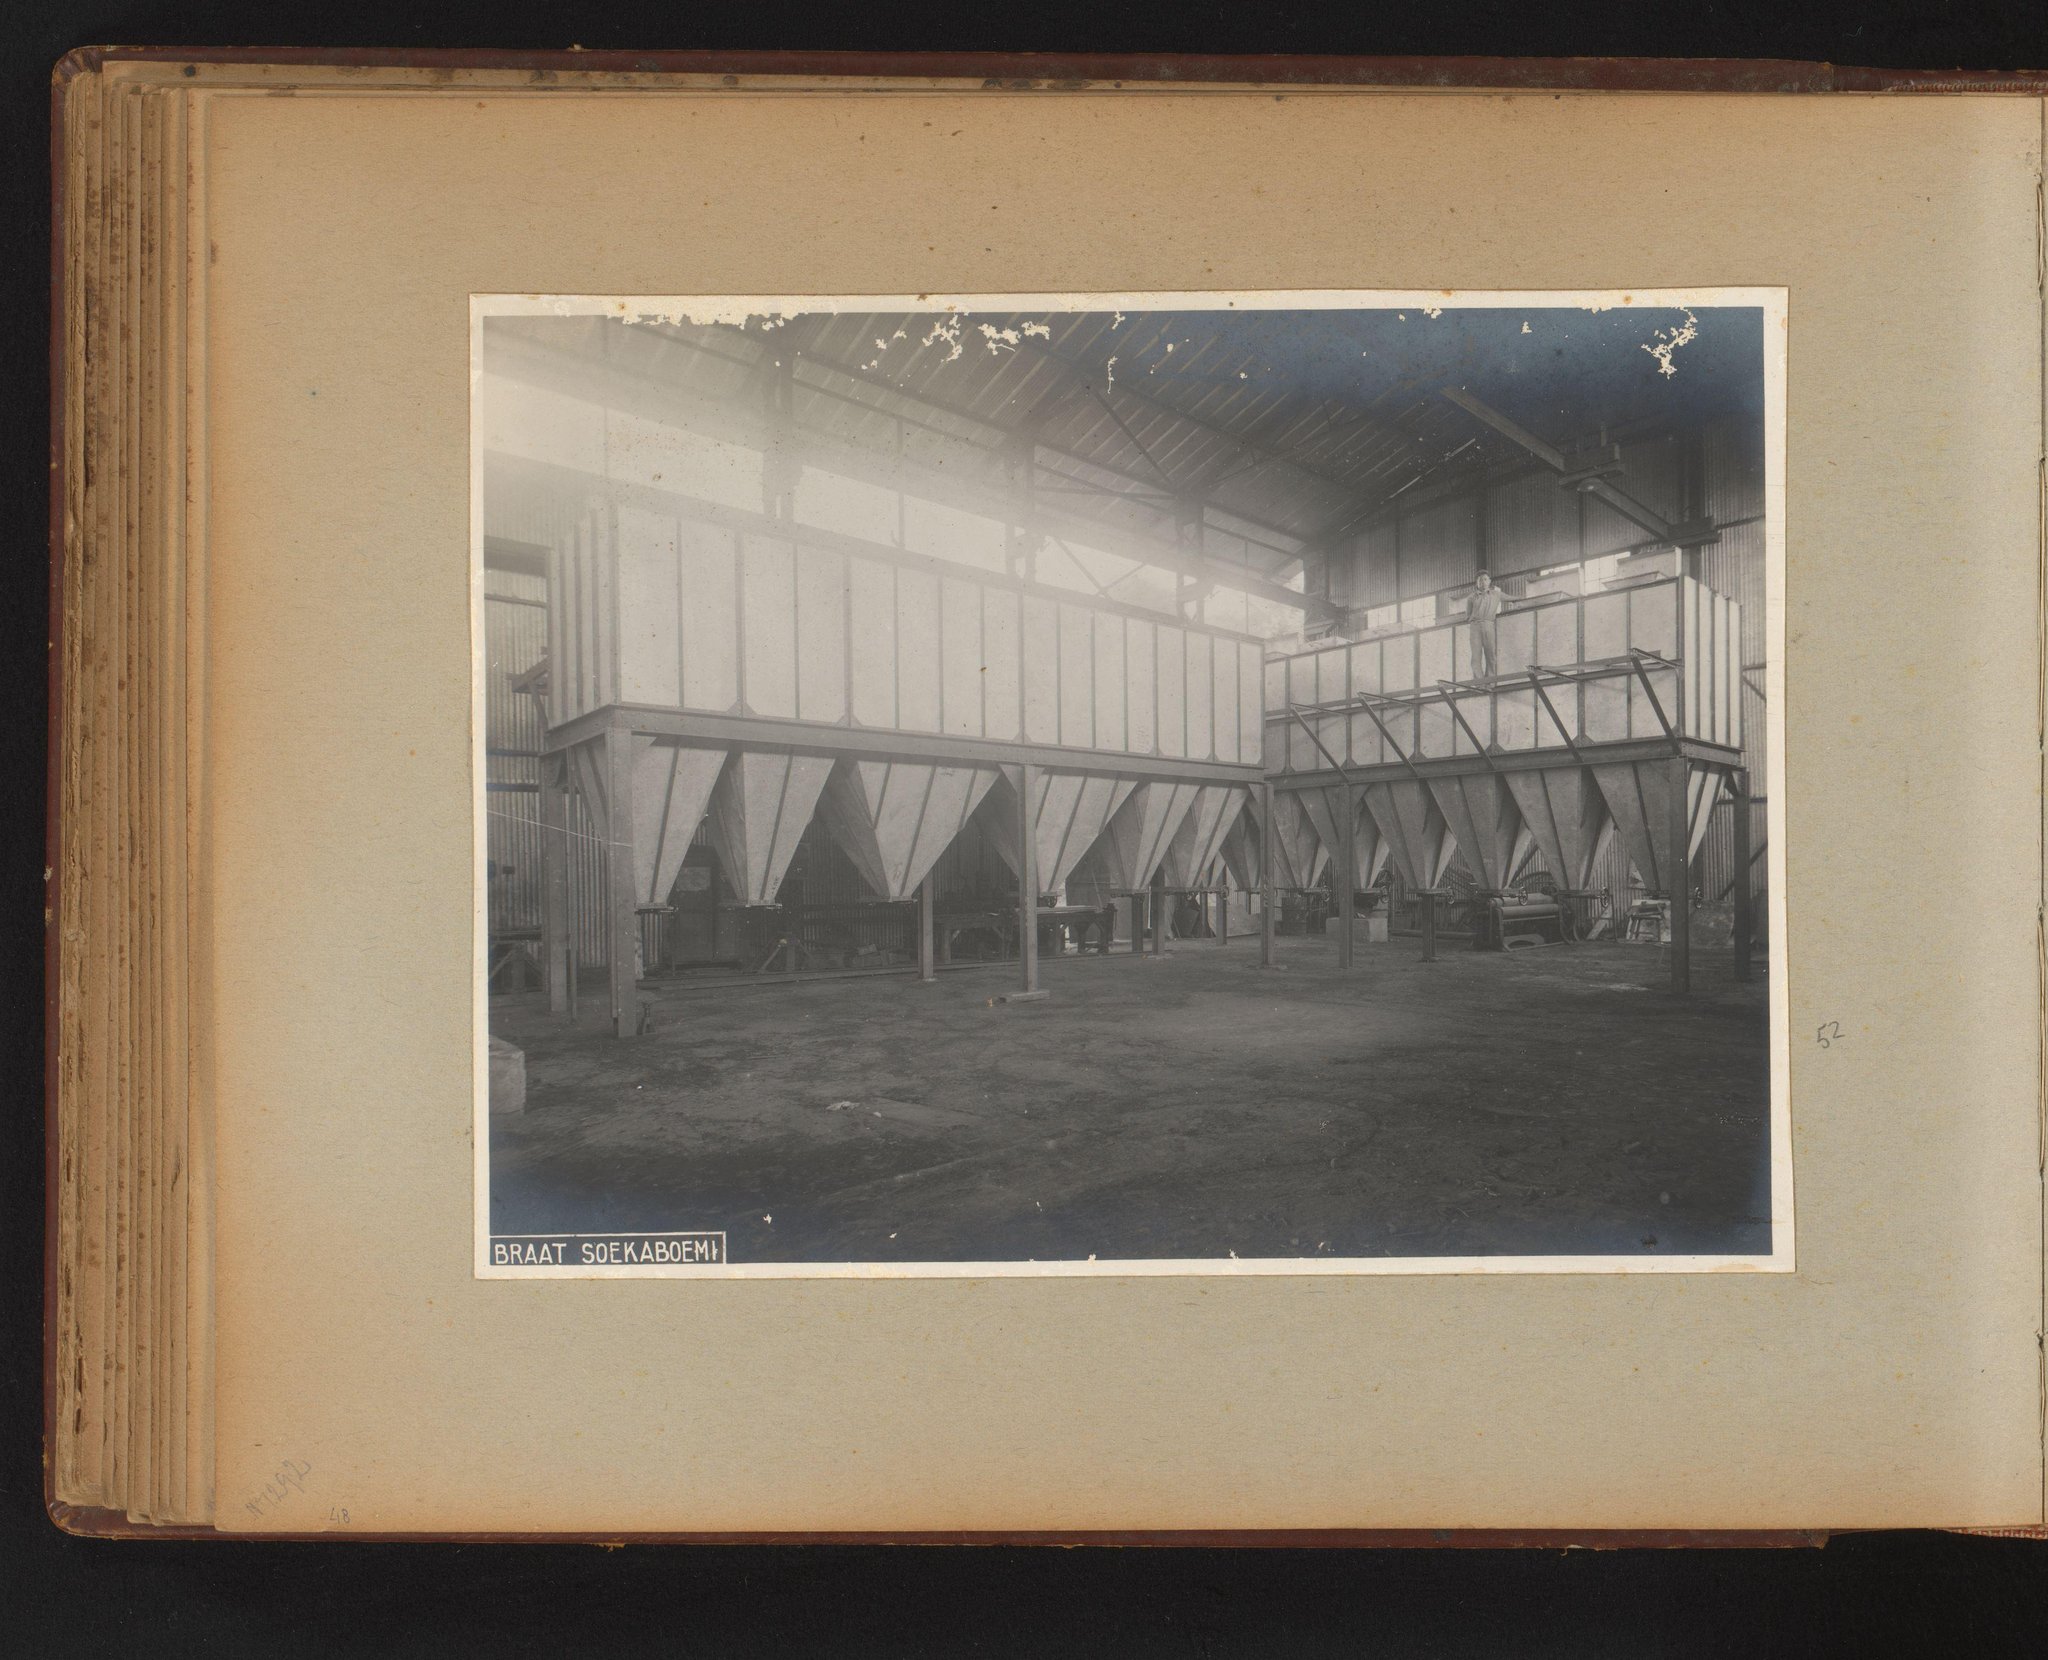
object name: photograph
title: Fabriekshal met installaties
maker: Anonymous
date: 1931-1937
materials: cardboard, photographic support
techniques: gelatin silver print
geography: soekaboemi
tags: factory-interior, machine shop, machines; parts of machines; tools and appliances, java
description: Albumblad met een foto van het interieur van een fabriekshal waarin twee voltooide installaties staan, waarschijnlijk bestemd voor de theefabriek Kertamanah. Onderdeel van een fotoalbum met foto's van machines en constructies van de N.V. Machinefabriek Braat te Soerabaja, Soekaboemi en Tegal uit de periode 1931-1937.